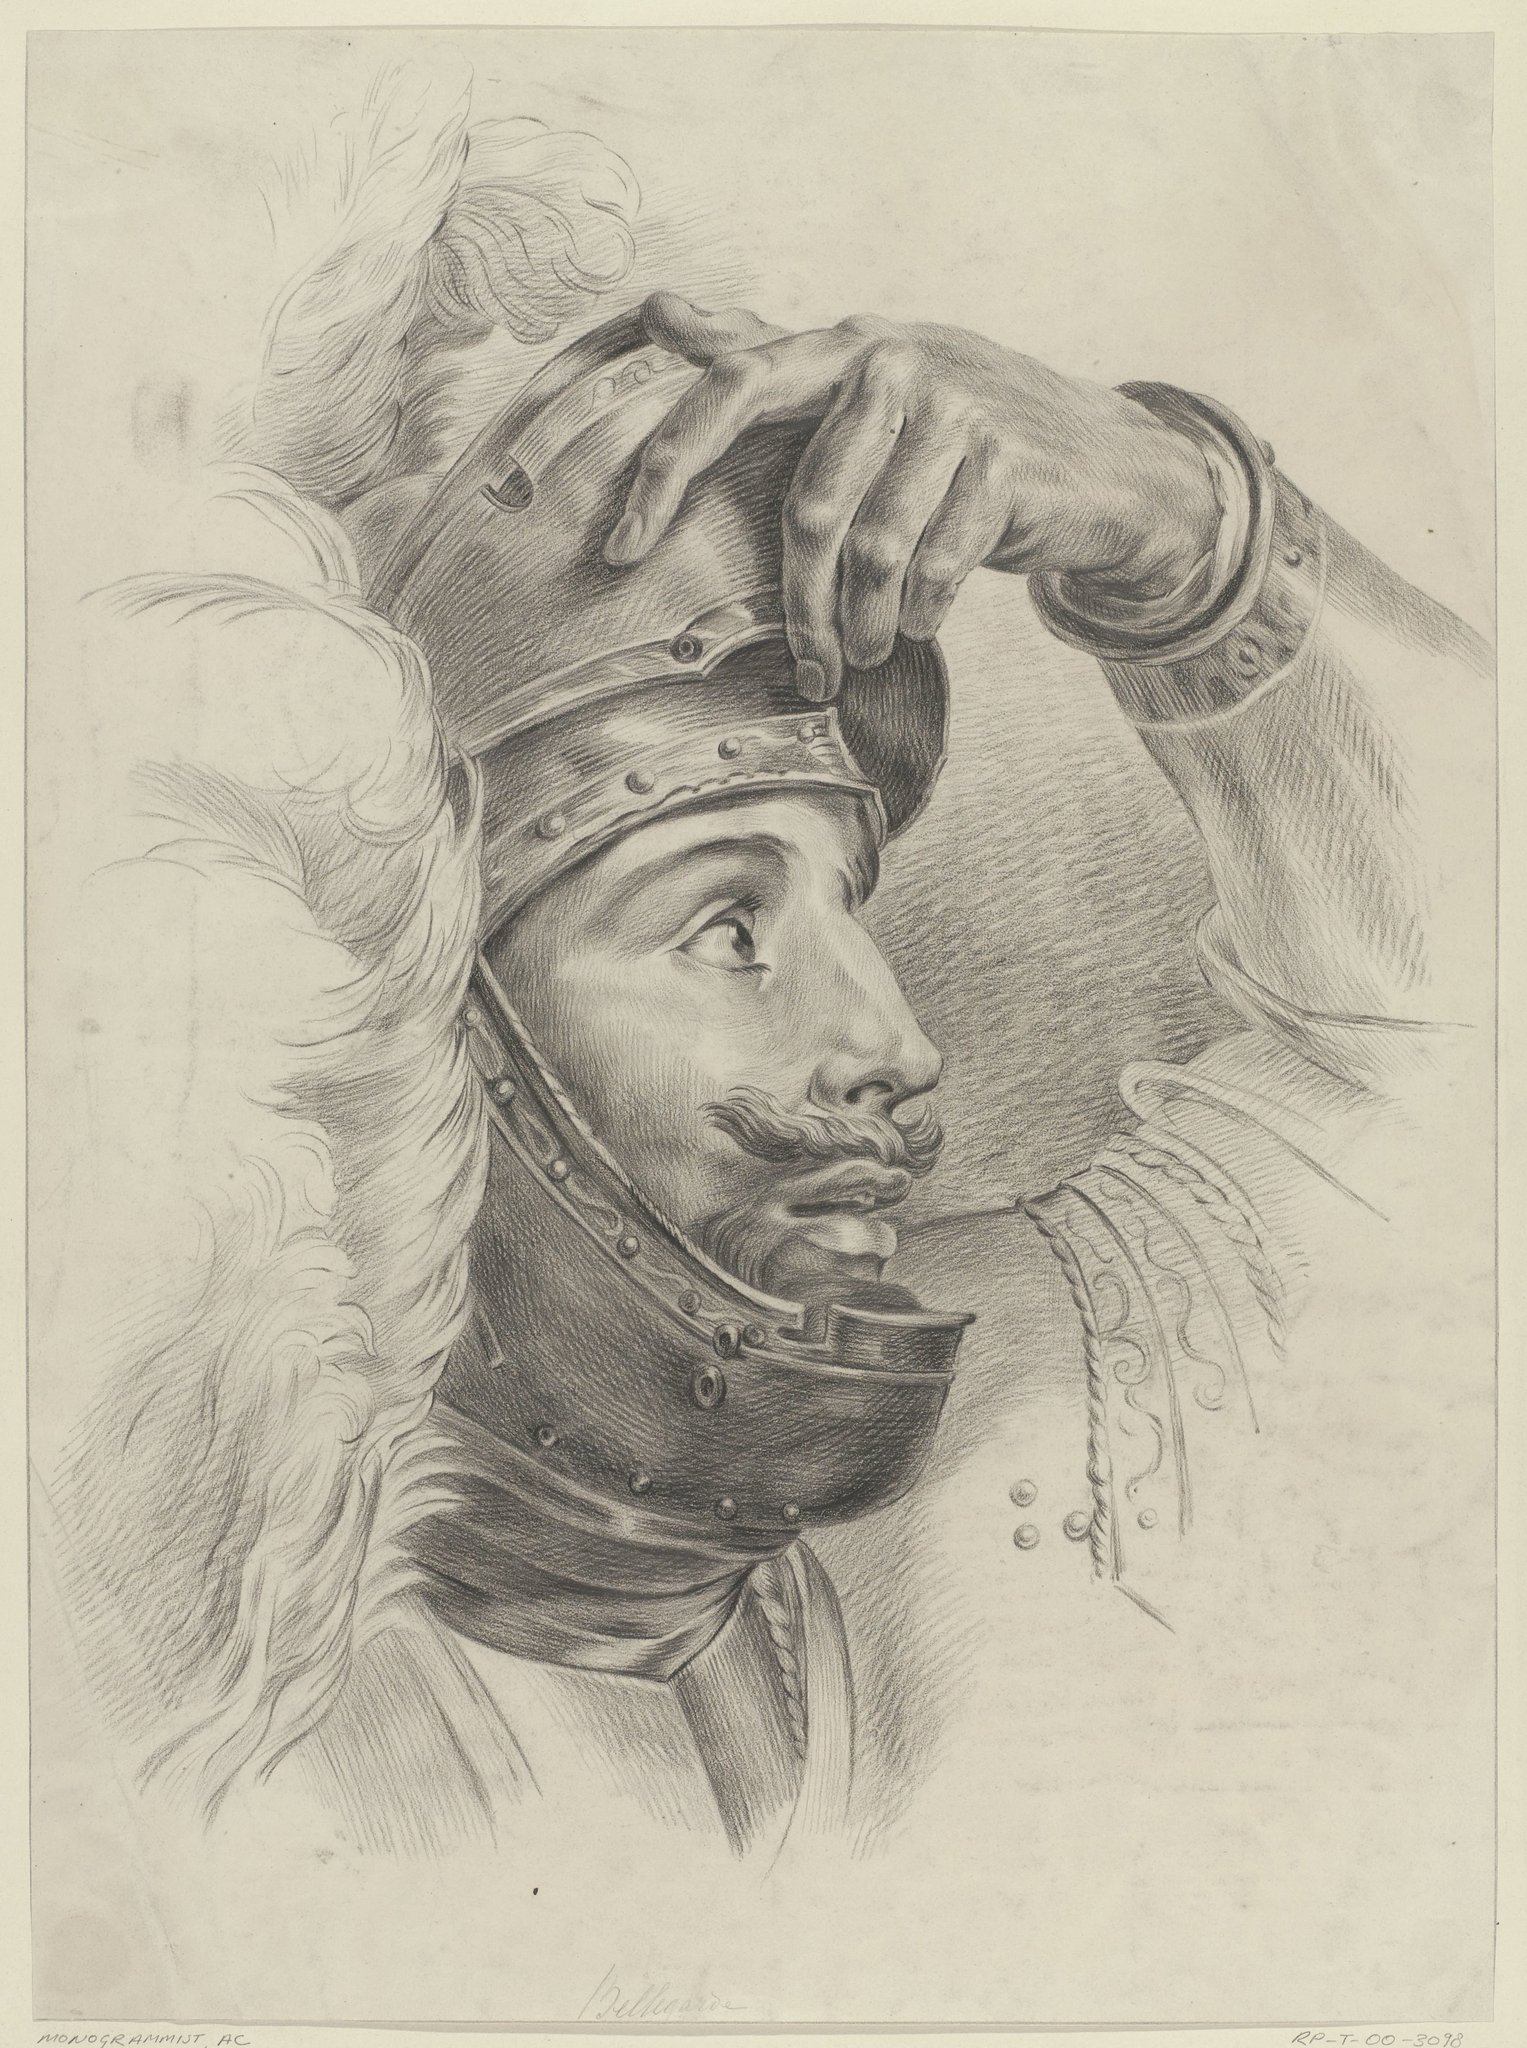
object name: drawing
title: Kop van een ridder, naar rechts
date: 1829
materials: chalk, paper